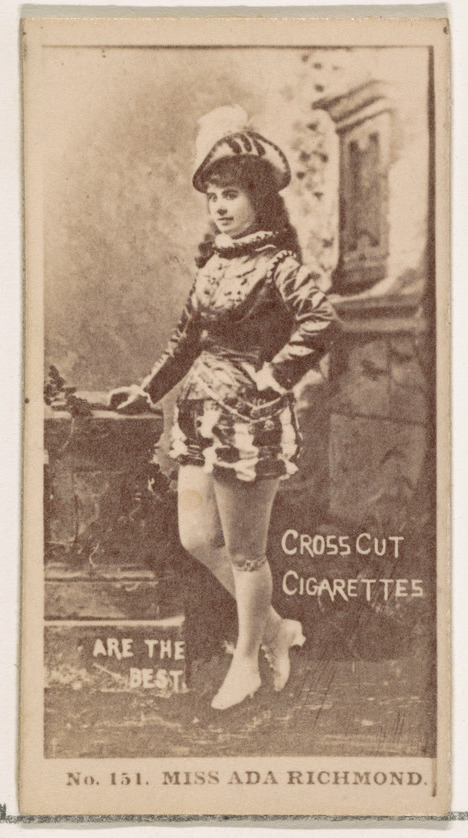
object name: print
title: Card Number 151, Miss Ada Richmond, from the Actors and Actresses series (N145-2) issued by Duke Sons & Co. to promote Cross Cut Cigarettes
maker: w. duke, sons & co.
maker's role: publisher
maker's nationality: american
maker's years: 1870-1920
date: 1880-1889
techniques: albumen silver print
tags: portraits,women,actresses